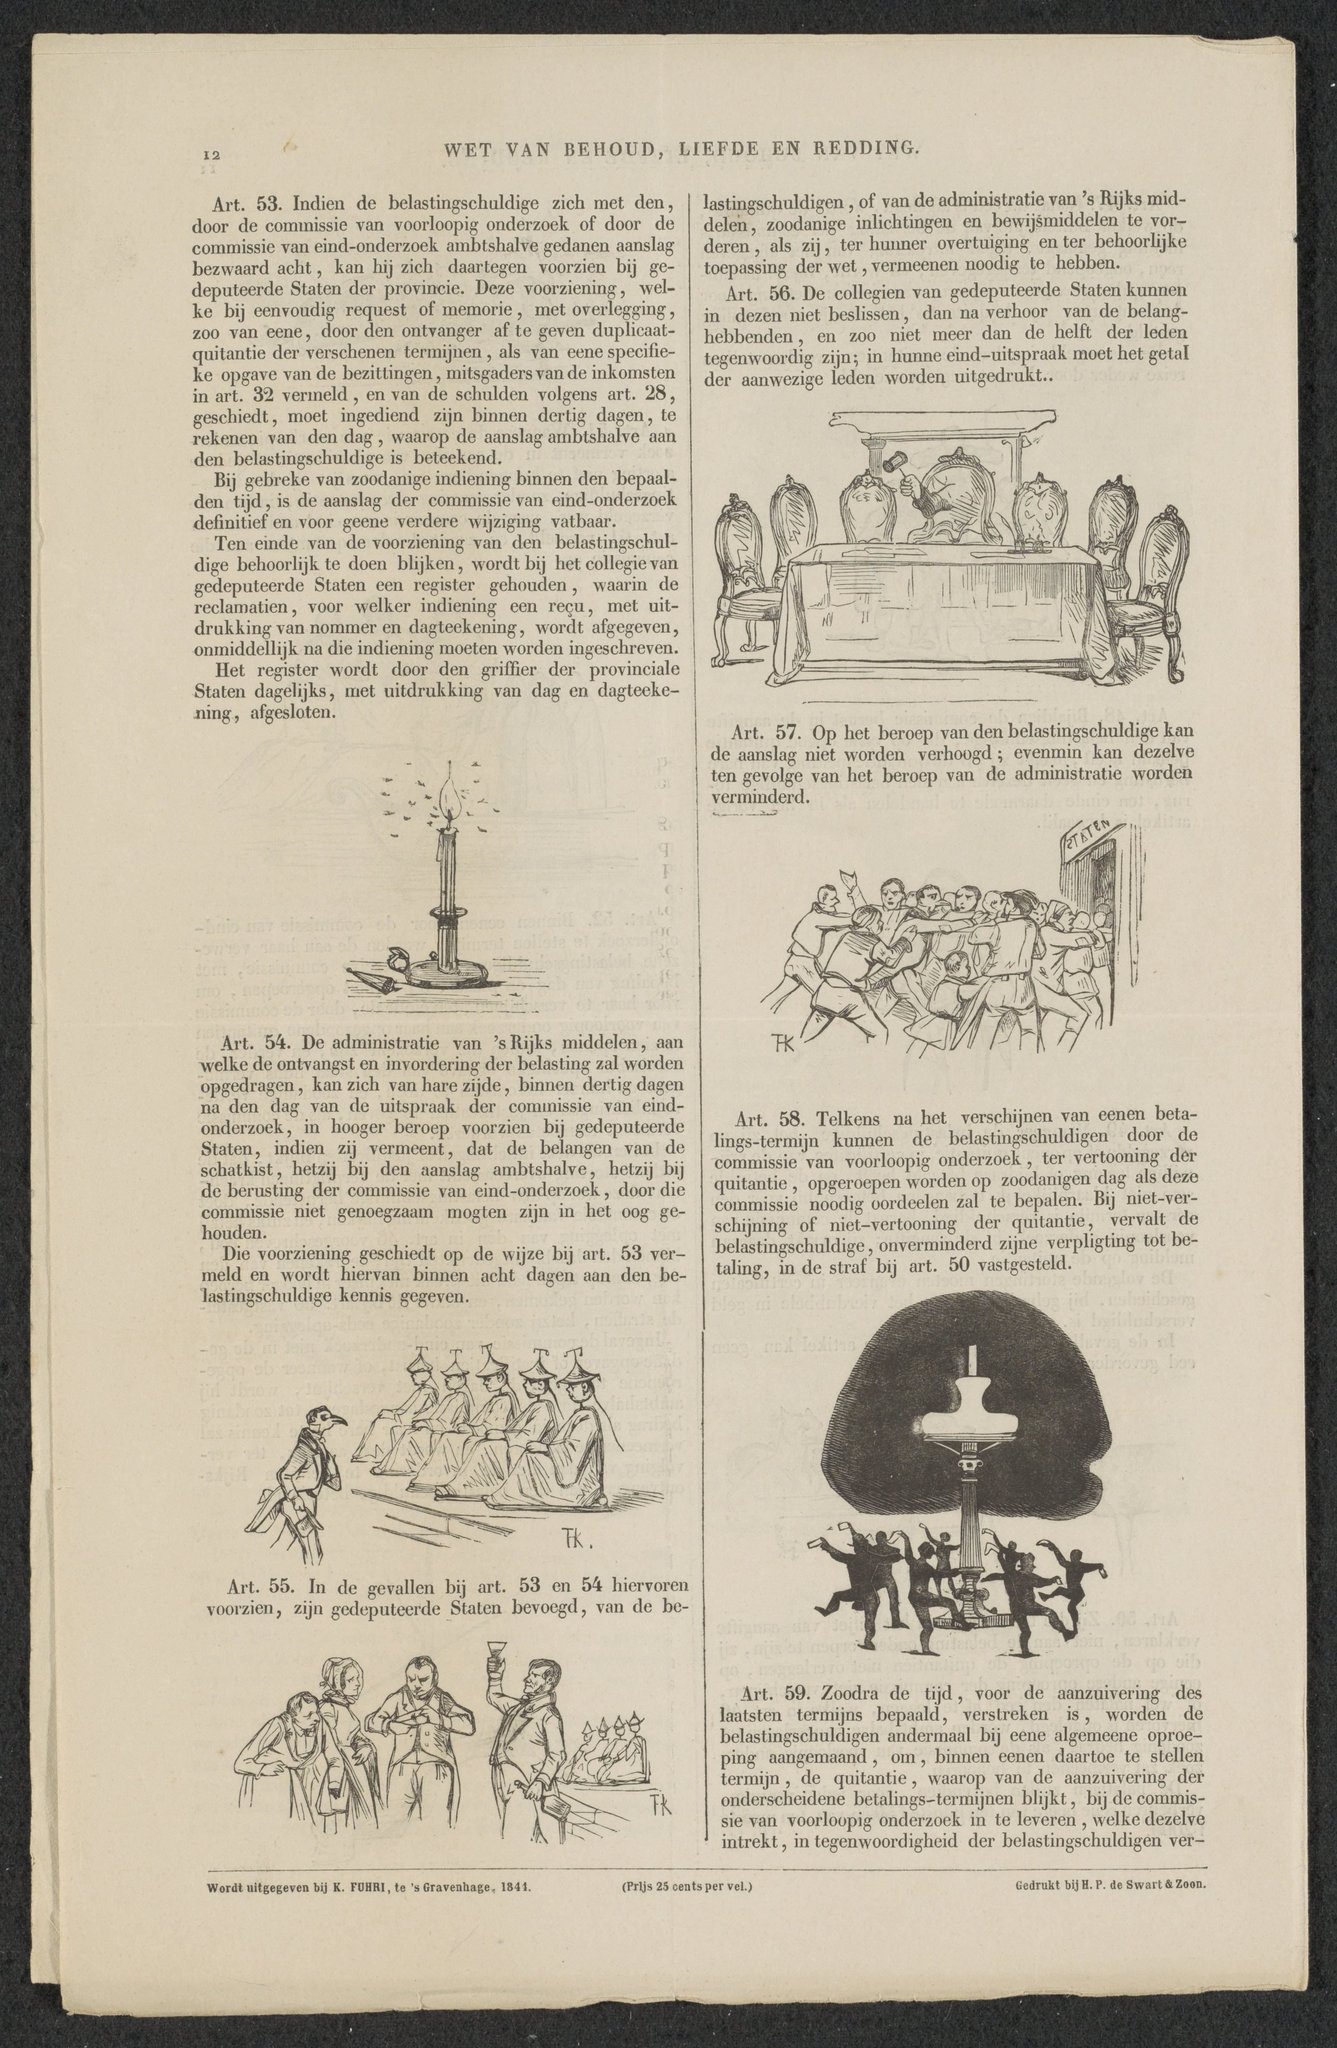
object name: print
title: Wet van Behoud, Liefde en Redding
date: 1844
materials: paper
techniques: letterpress printing, engraving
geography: the hague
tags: floris adriaan van hall, organization of trade and finance, taxes and financial administration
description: Bladzijde 12 met artikels 53-59 van de 'Wet van Behoud, Liefde en Redding'. Een satire in zestien bladzijden op de aansporing tot deelneming in de (zogenaamde) vrijwillige 3% geldlening uitgeschreven in maart 1844 door minister F.A. van Hall. Achterzijde van een dubbelgevouwen blad bedrukt op alle zijden.